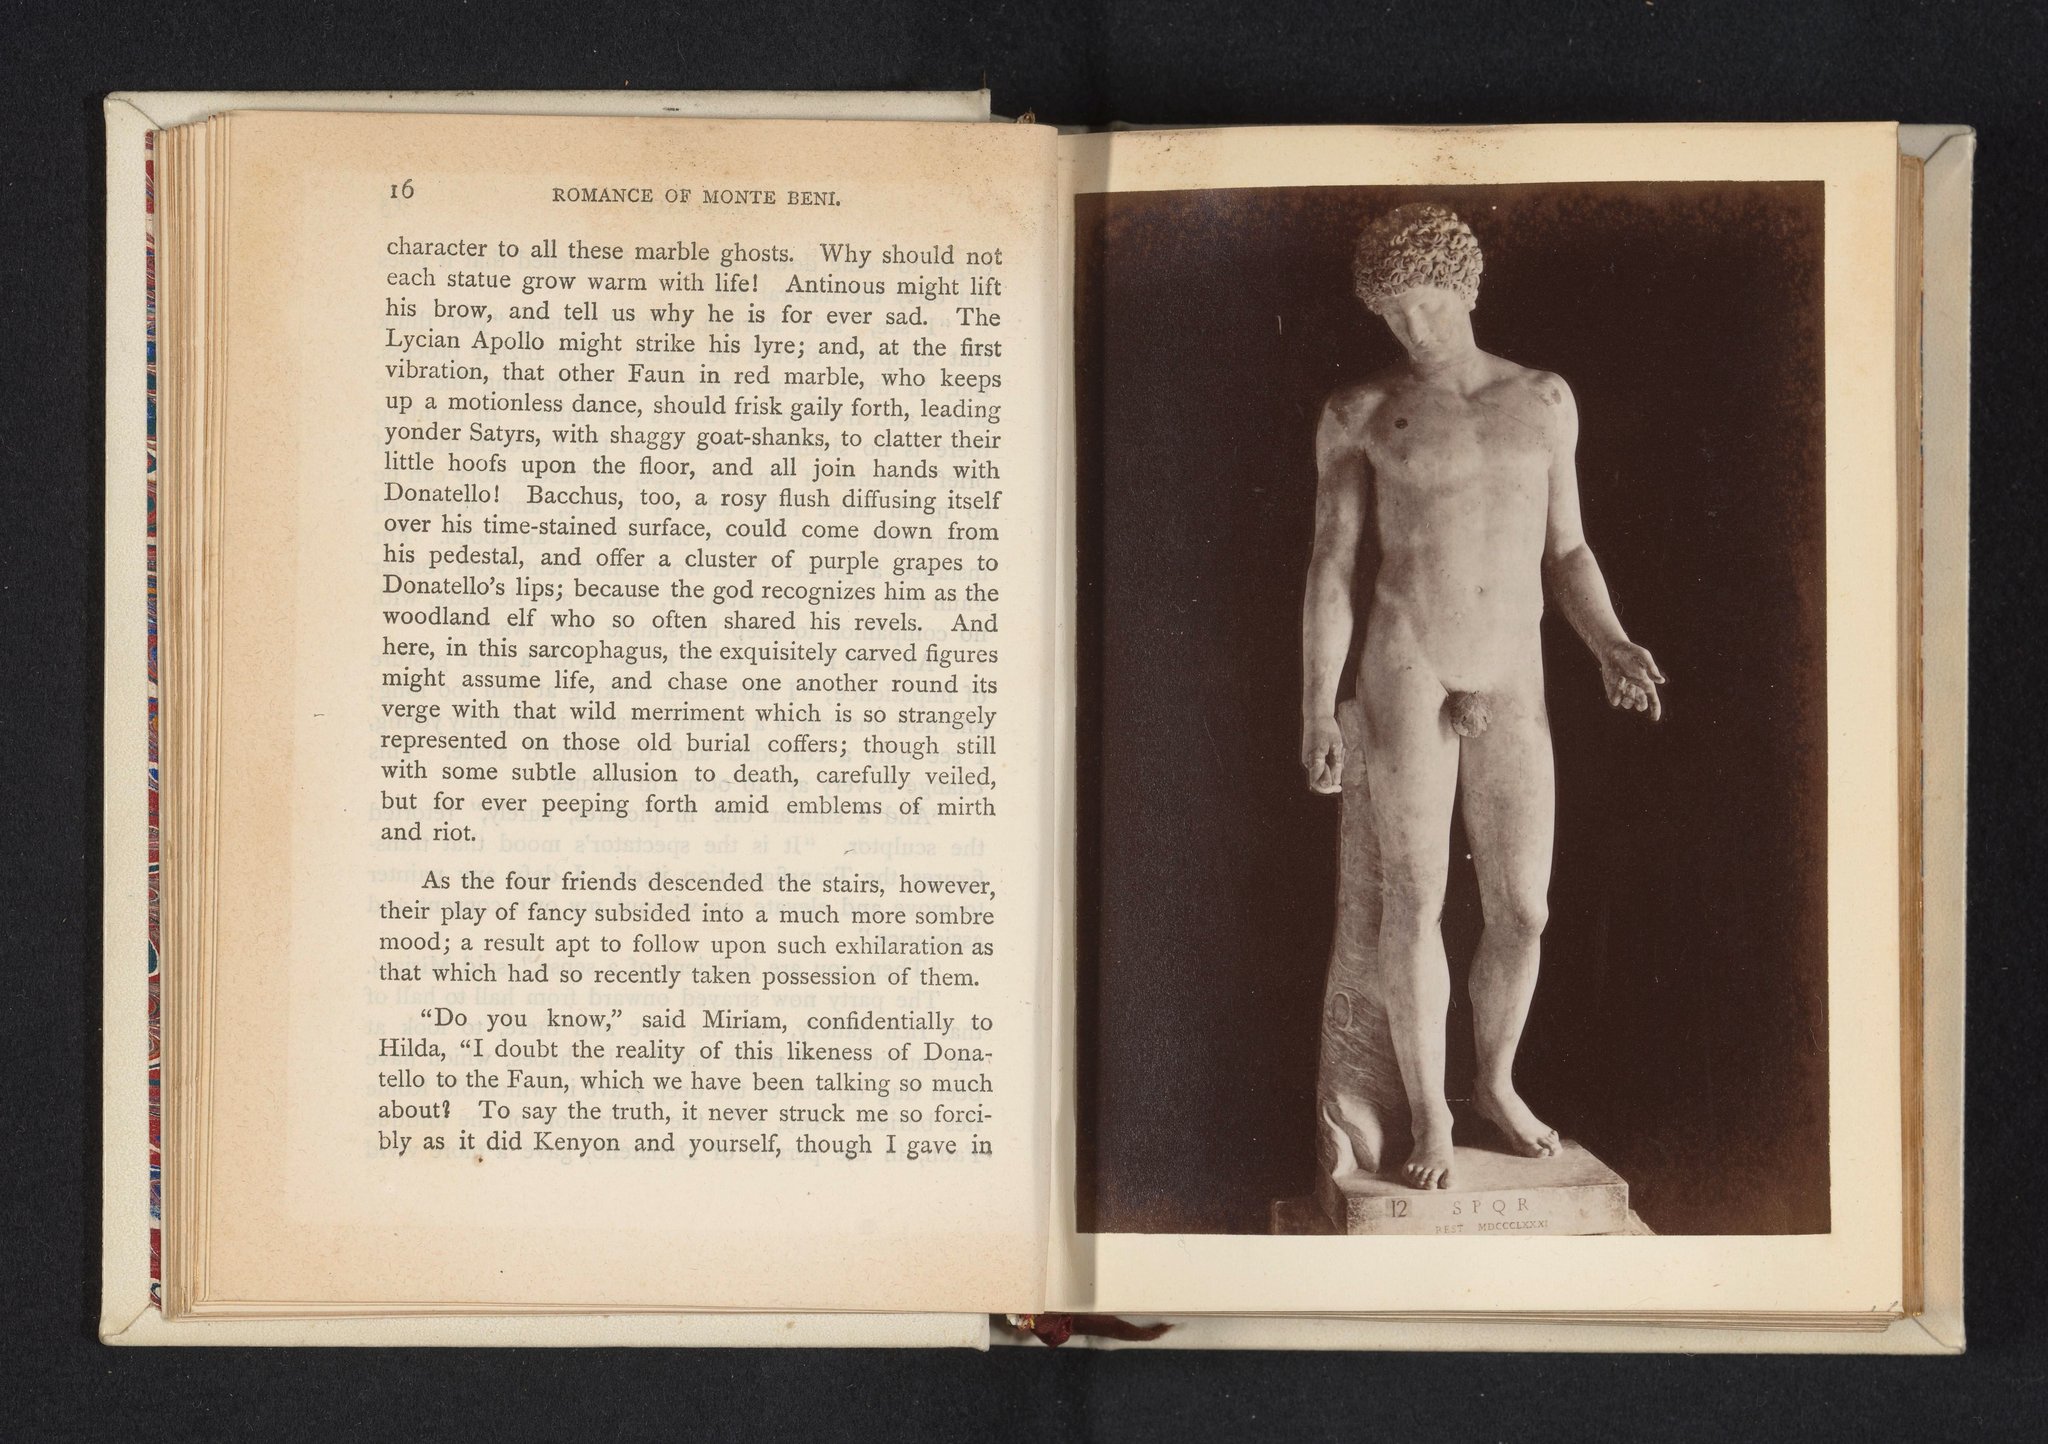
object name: photograph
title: Capitolijnse Antinoüs in de Capitolijnse Musea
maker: Anonymous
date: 1850-1860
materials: photographic support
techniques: albumen print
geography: rome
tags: piece of sculpture, reproduction of a piece of sculpture